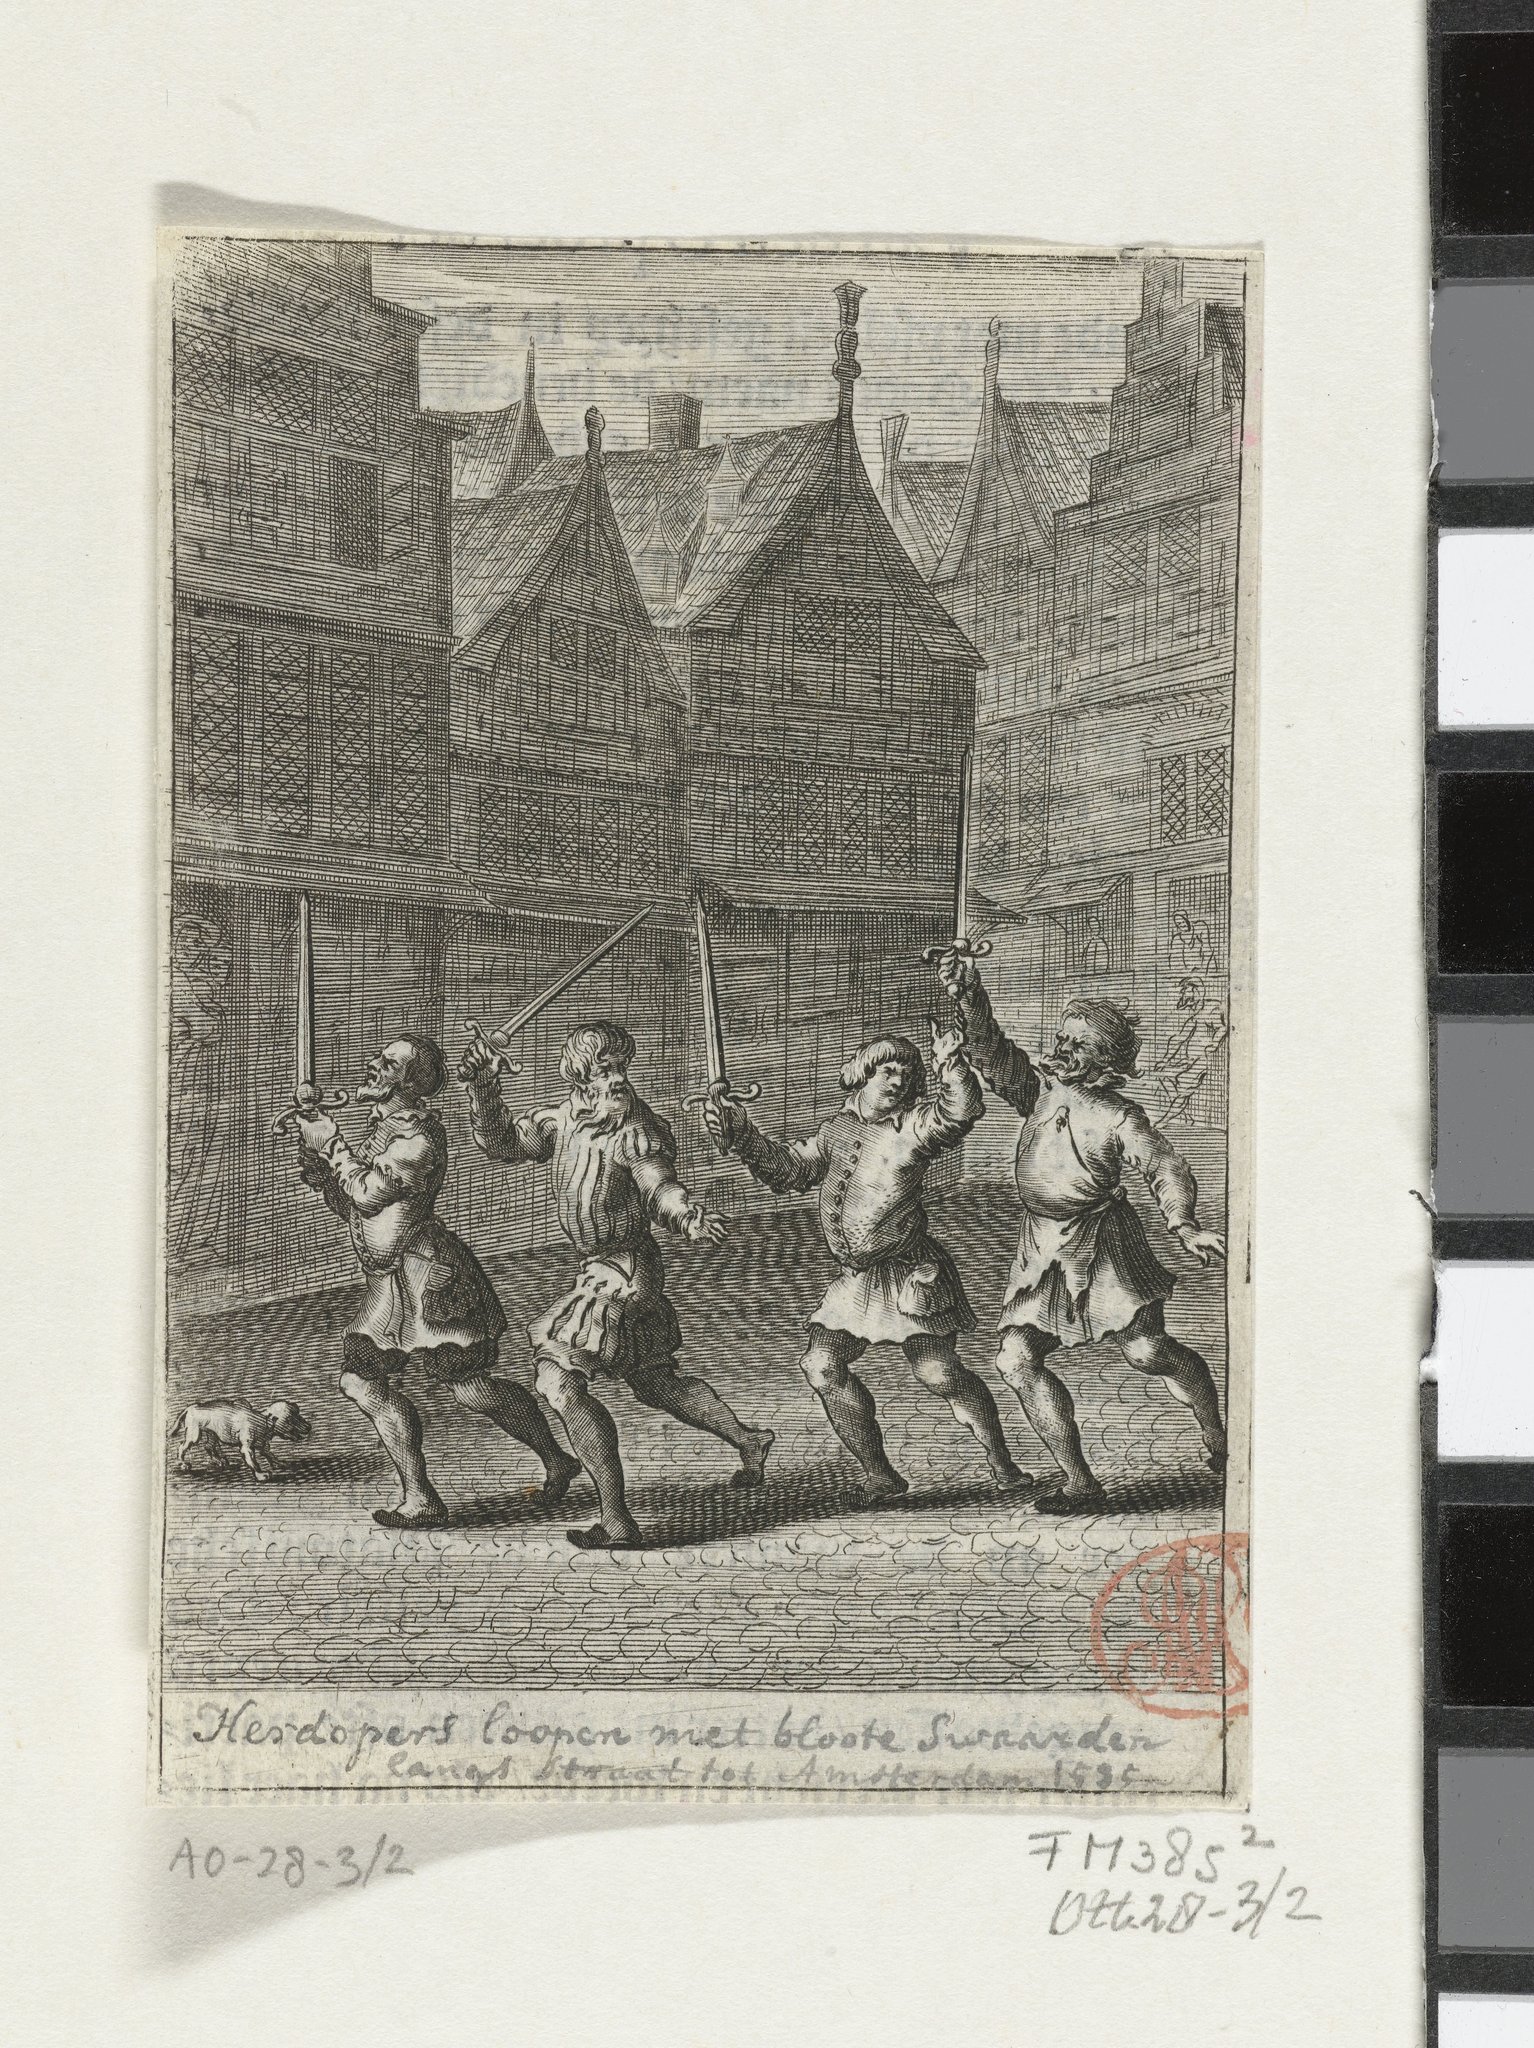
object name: history print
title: Zwaardlopers te Amsterdam, 1534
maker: Anonymous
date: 1657-1659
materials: paper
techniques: engraving, etching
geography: northern netherlands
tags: amsterdam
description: Illustratie voor: L. Hortensius, Het boeck D. Lamberti Hortensii (...). Van den oproer der weder-dooperen, J.J. Schipper, Amsterdam 1659. De prenten in deze uitgave zijn gekopieerd naar de anonieme gravures in de eerste uitgave van 1614. Naar het verloren gegane schilderij van Barend Dircksz. in het oude stadhuis te Amsterdam.